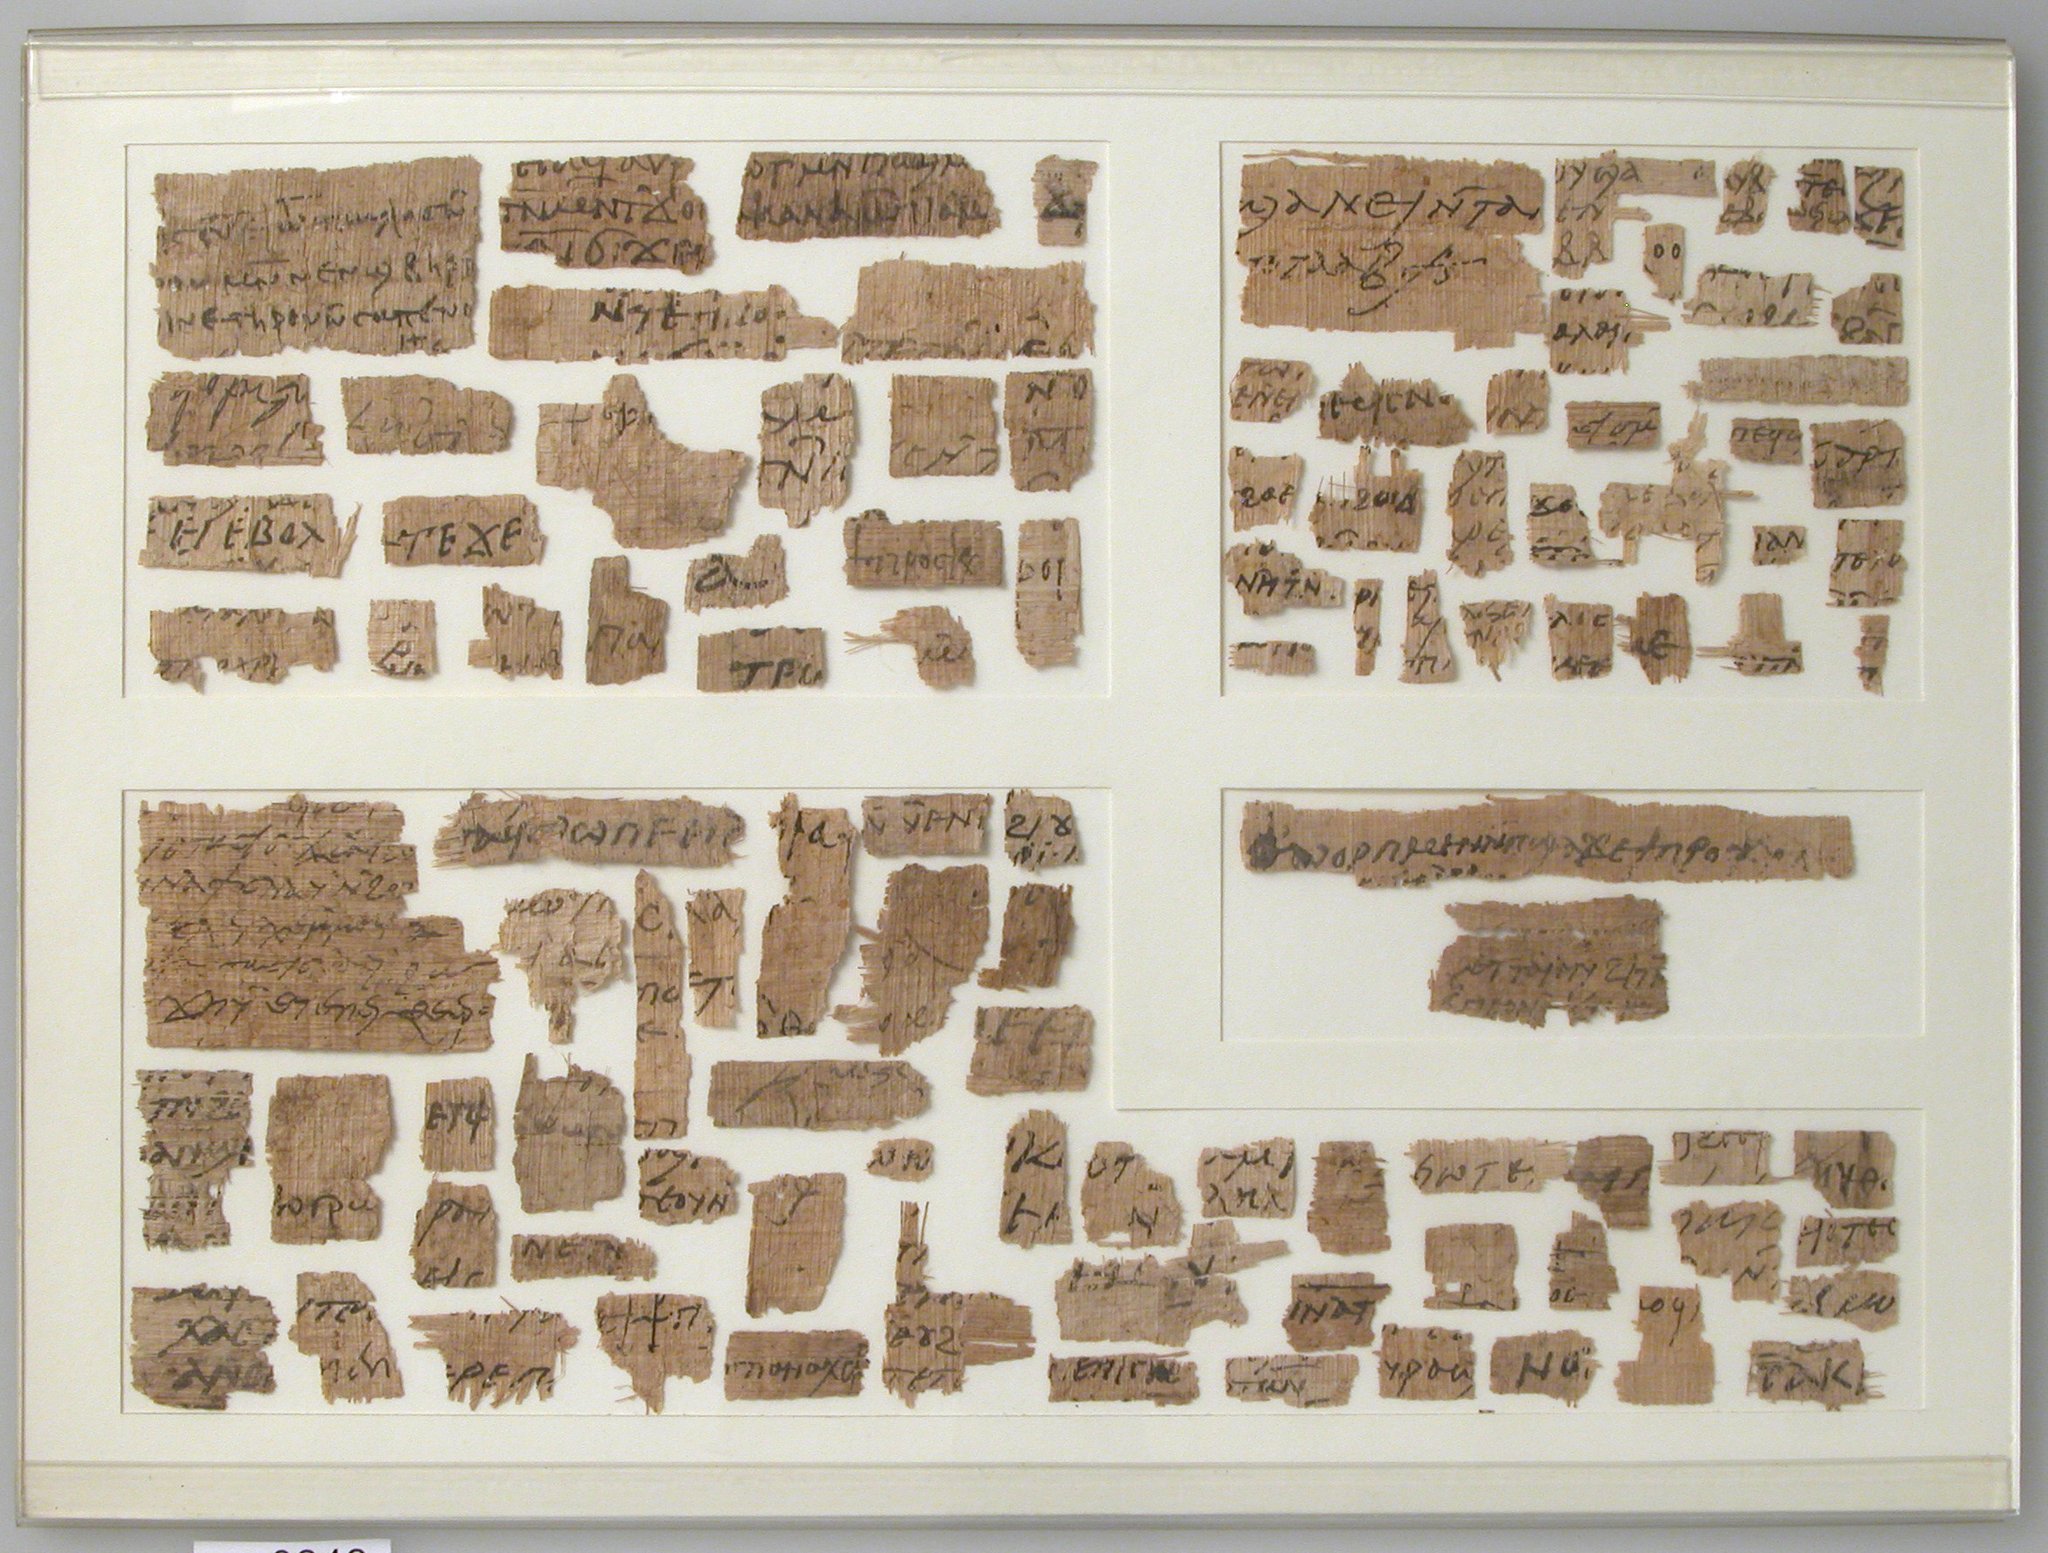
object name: fragment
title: Papyri Fragments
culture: coptic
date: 601-700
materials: ink, papyrus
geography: egypt